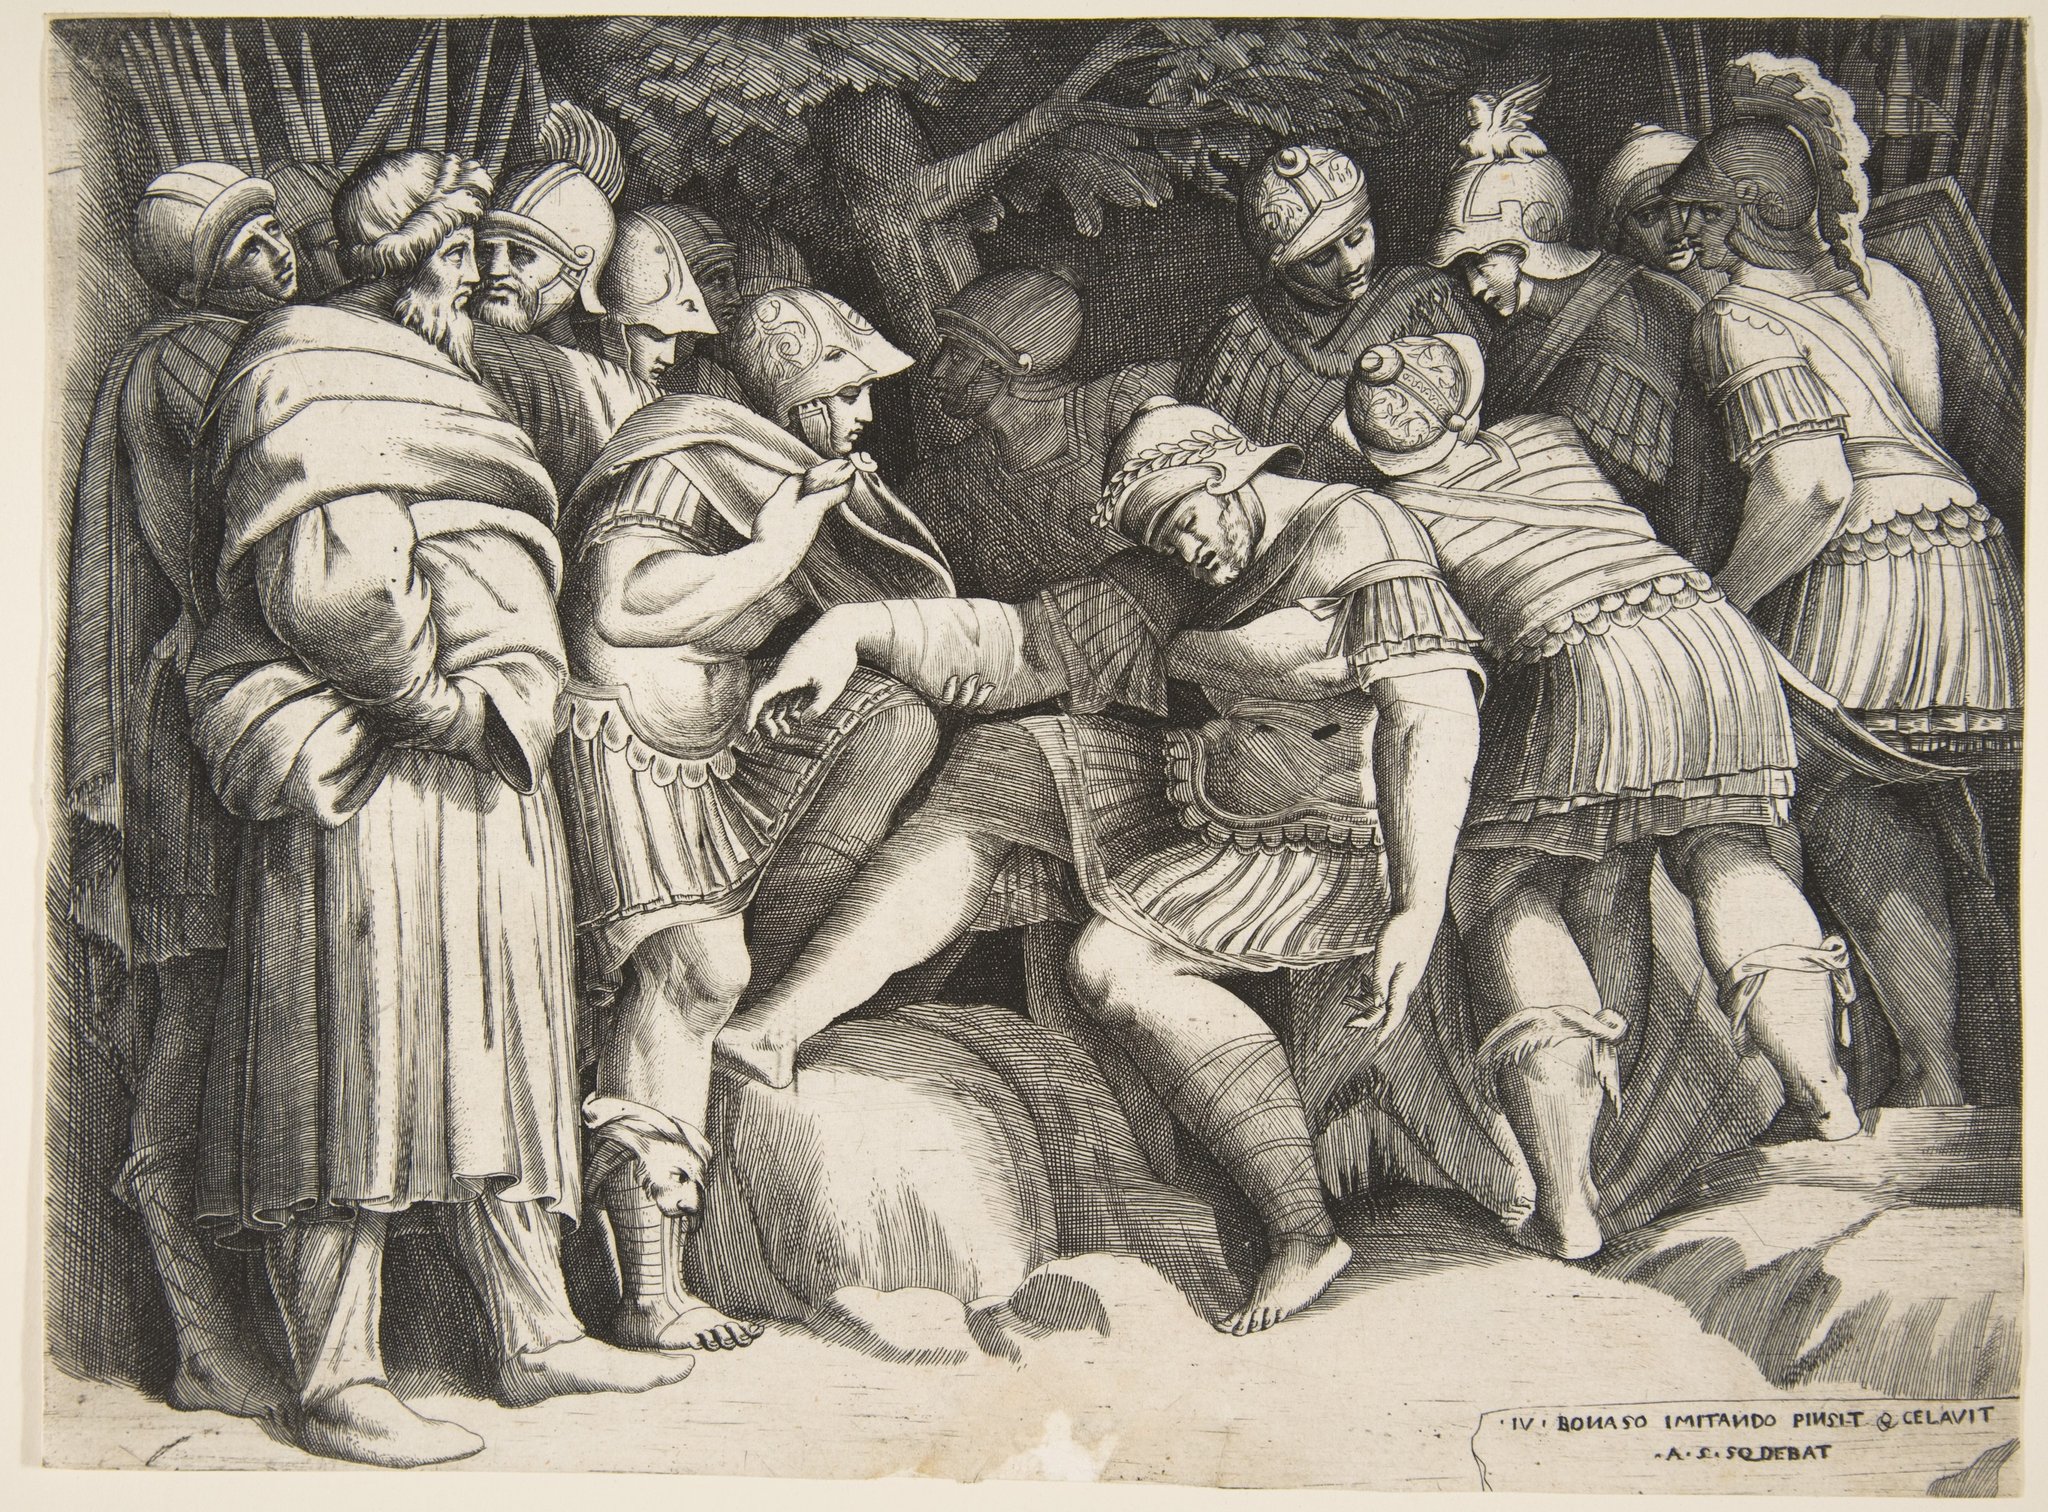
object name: print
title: The wounder soldier Scipio in the centre surrounded by figures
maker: giulio bonasone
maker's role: artist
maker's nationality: italian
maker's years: 1510-1576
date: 1531-1576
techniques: engraving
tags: soldiers,men